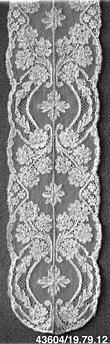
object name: lappet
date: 1801-1833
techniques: lace